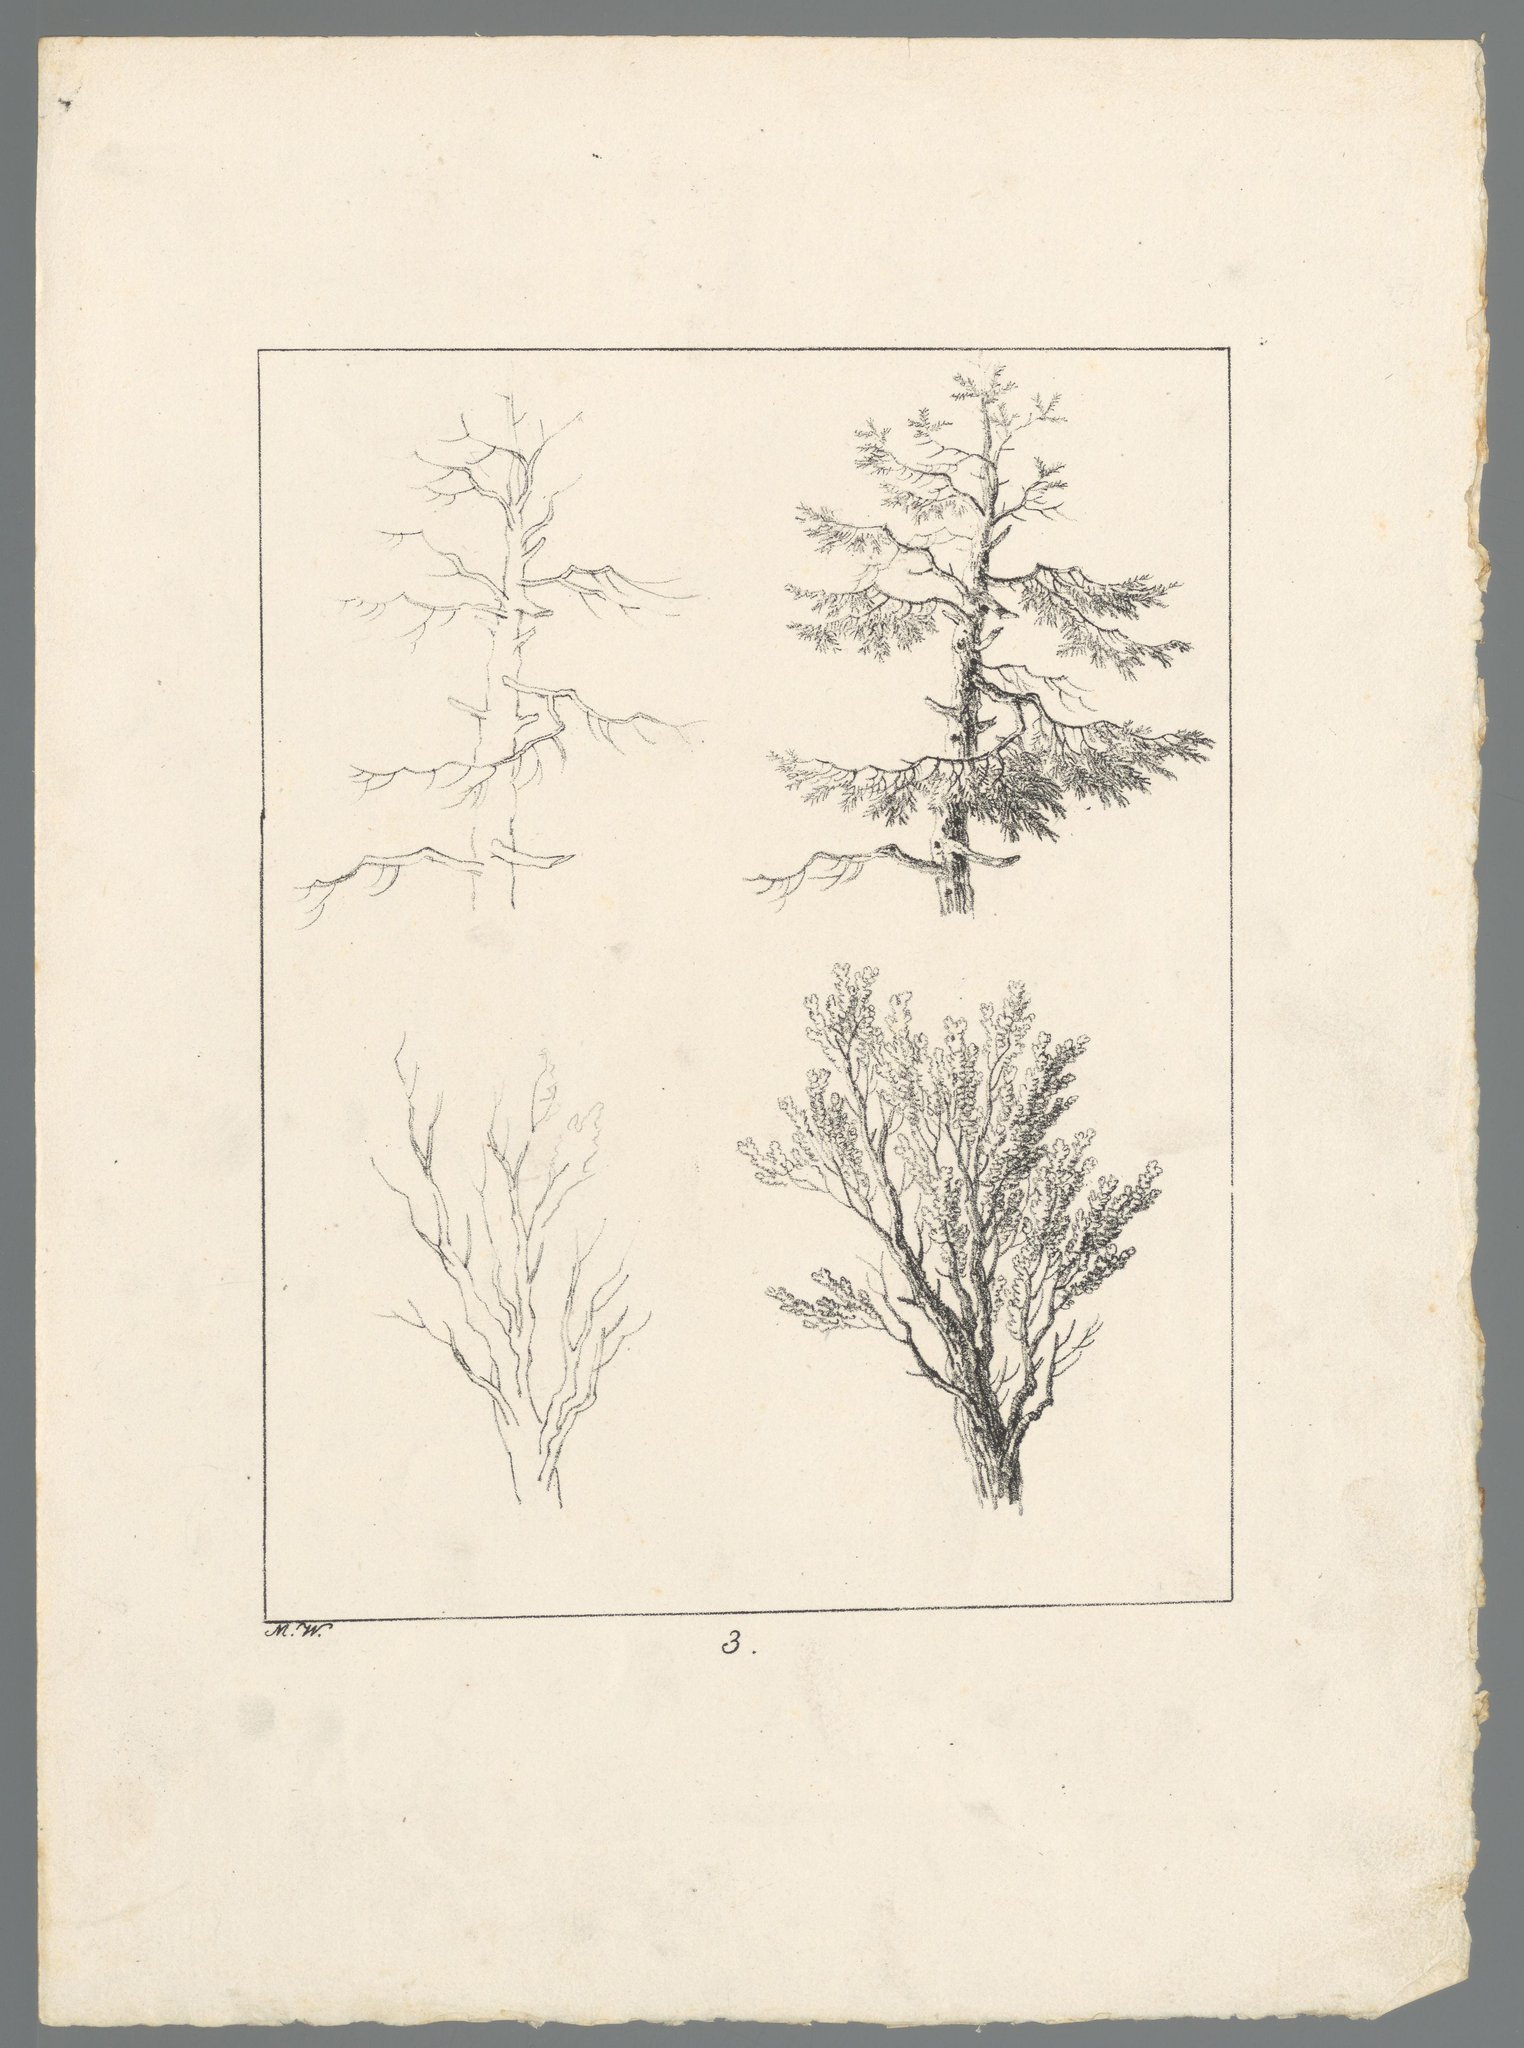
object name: print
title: Vier boomtakken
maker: max josef wagenbauer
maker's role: print maker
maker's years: 1774-1829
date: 1823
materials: paper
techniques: lithograph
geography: munich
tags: plants; vegetation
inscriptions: collector's mark: Lugt 2228, collector's mark: Lugt 2760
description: Prent behoort tot het eerste deel van de serie 'Vorlagen für Landschaft-zeichner'. Dit eerste deel bevat twintig prenten.